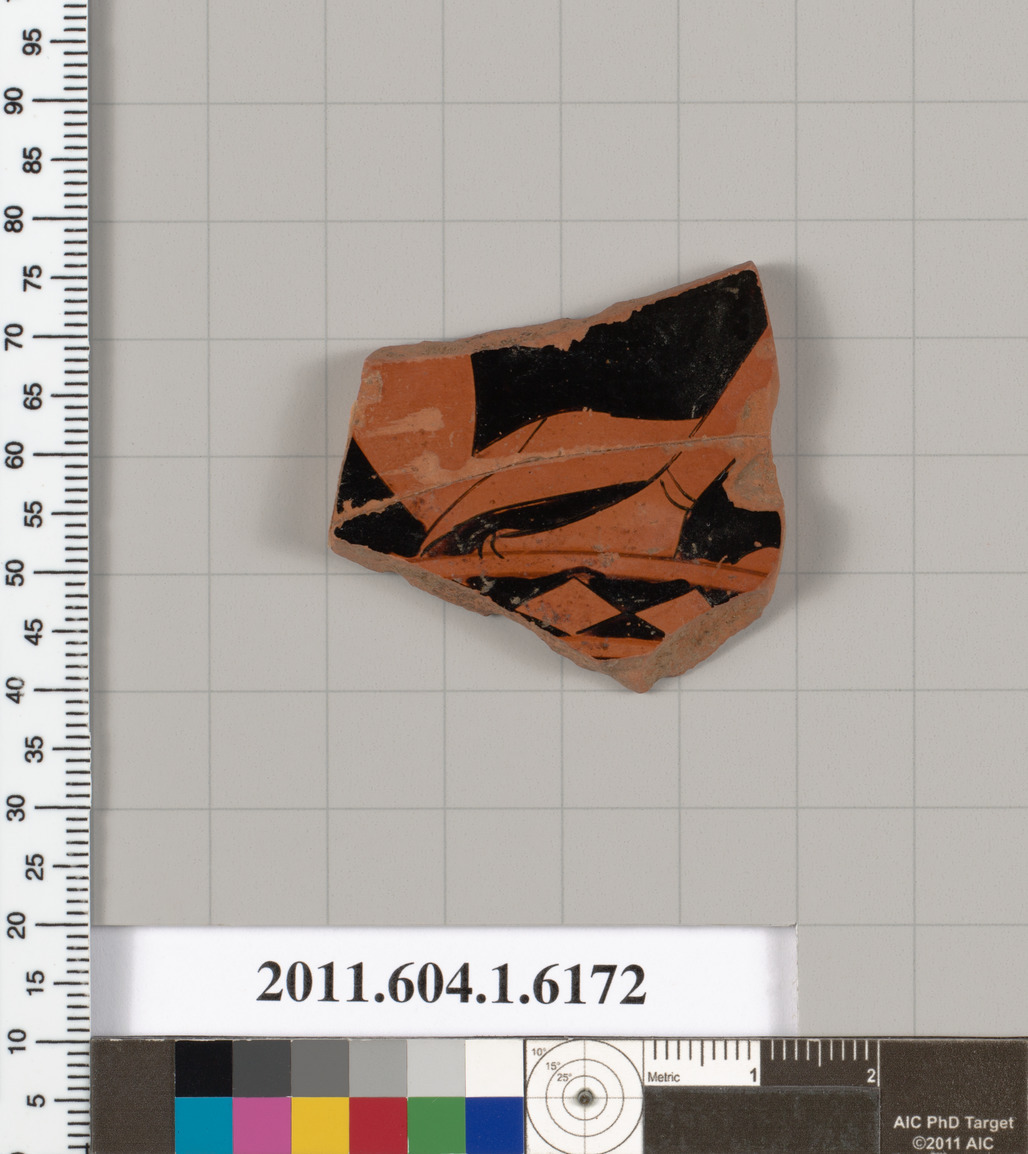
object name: kylix fragment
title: Terracotta fragment of a kylix (drinking cup)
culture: greek, attic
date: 520-500 BCE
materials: terracotta